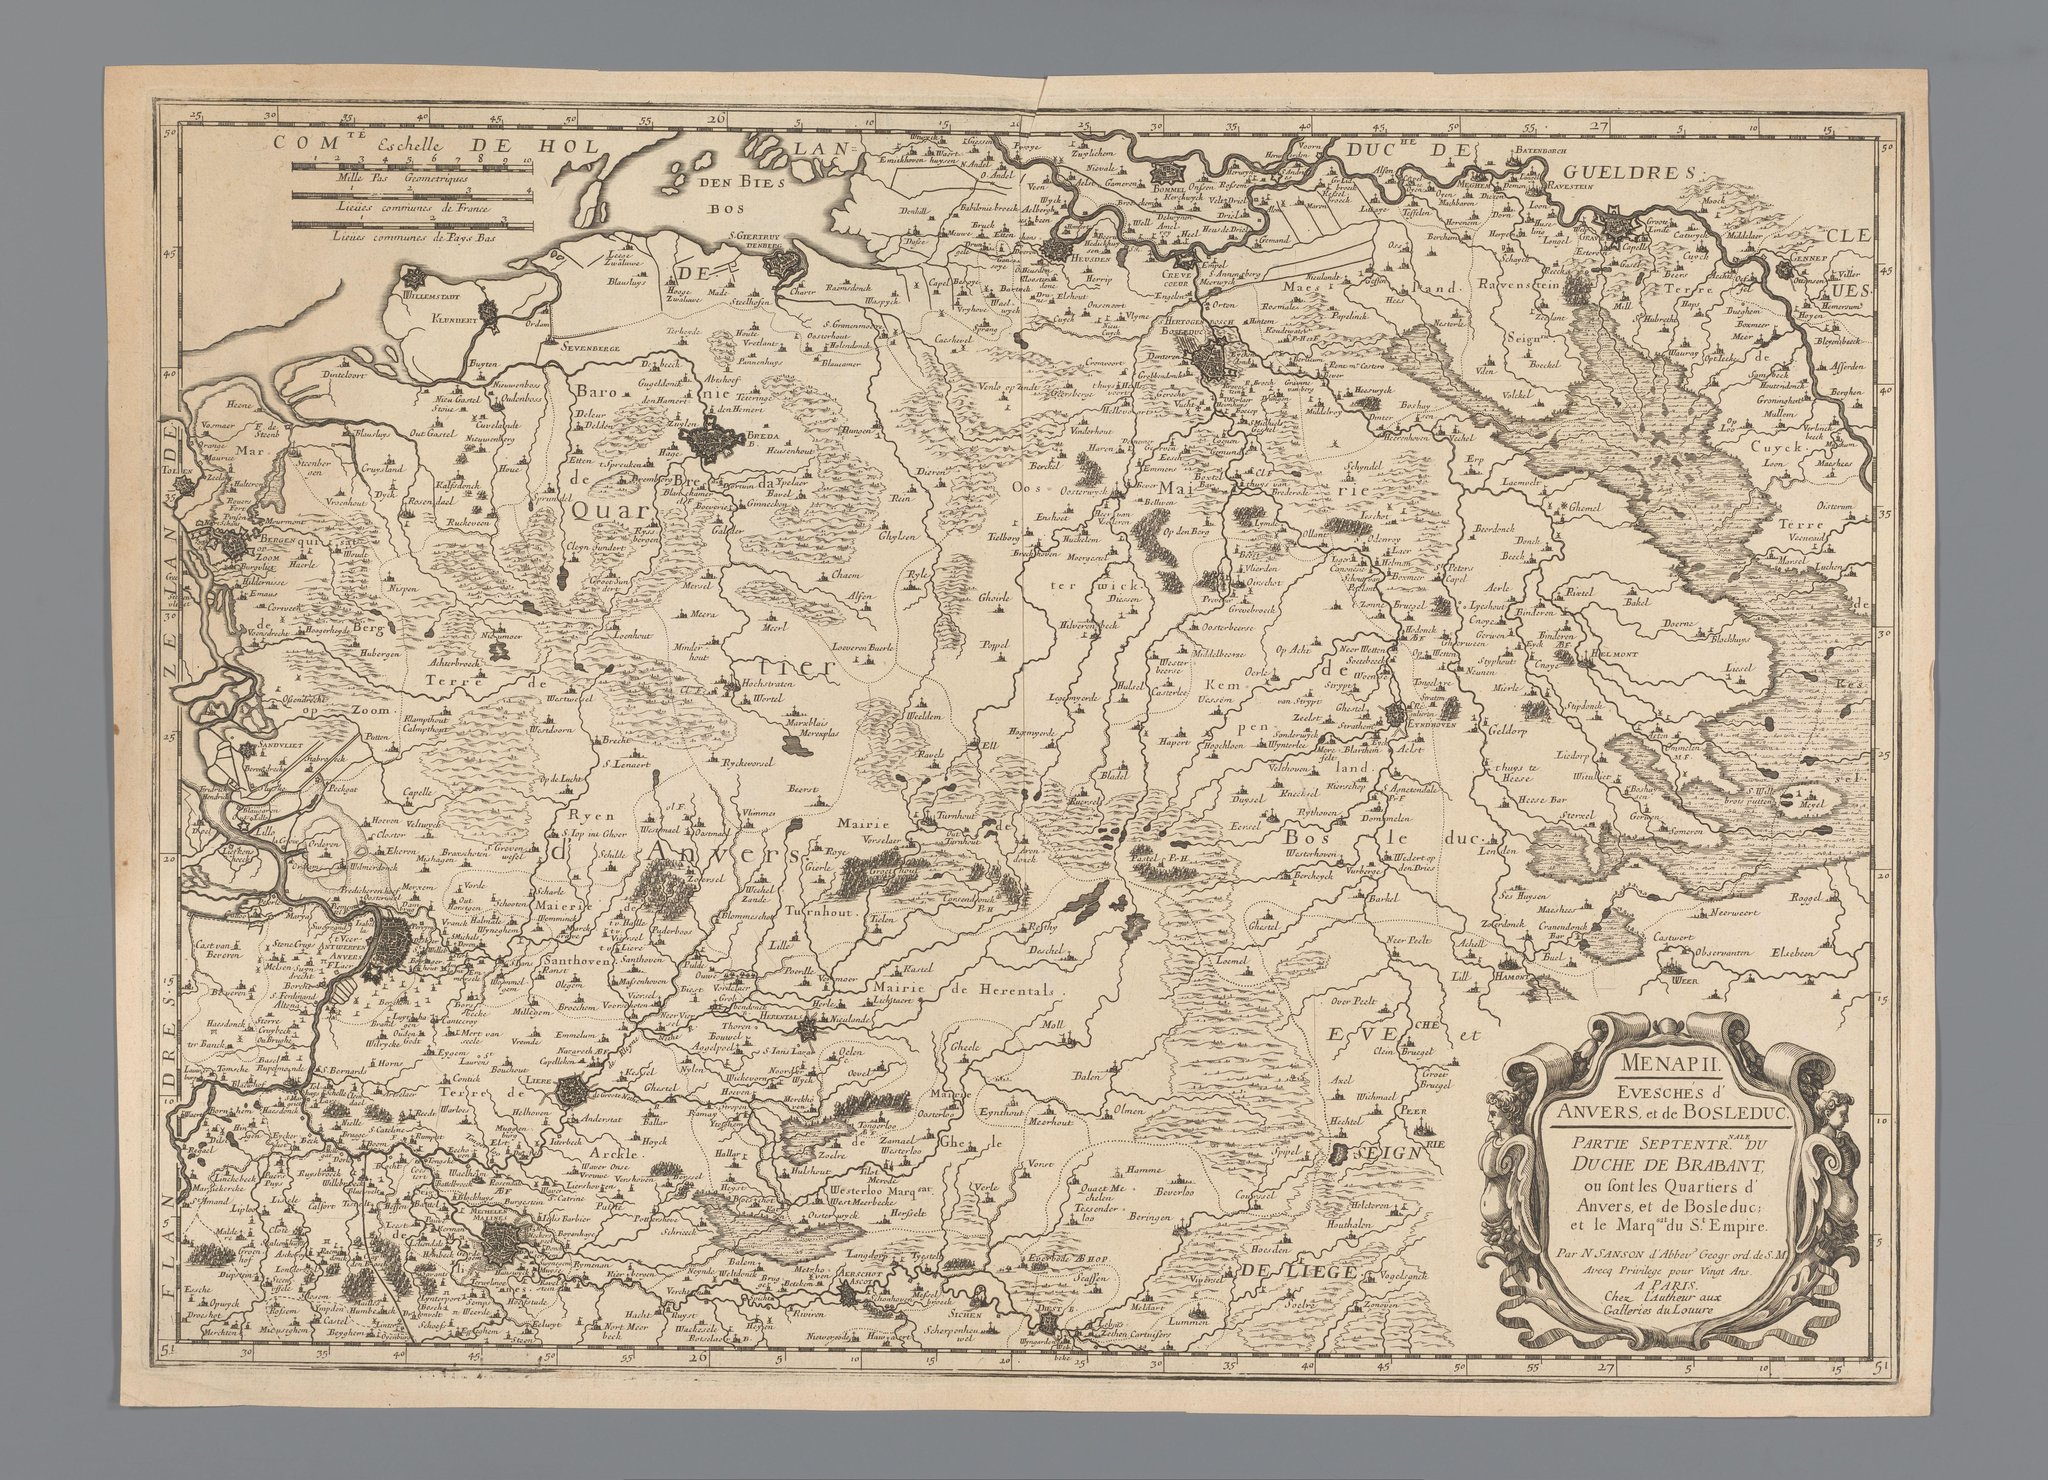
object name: map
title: Menapii. Eveschés d'Anvers, et de Bosleduc. Partie Septentr.nale du Duche de Brabant (...)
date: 1674-1730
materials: paper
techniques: etching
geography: paris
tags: maps of separate countries or regions, brabant, antwerp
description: Kaart van een deel van het hertogdom Brabant. Rechtsonder de titelcartouche. Linksboven drie schaalstokken: 10 Mille Pas Geometriques / 4 Lieues communes de France / 3 Lieues communes de Pays Bas. De kaart is voorzien van een gradenverdeling langs de randen.